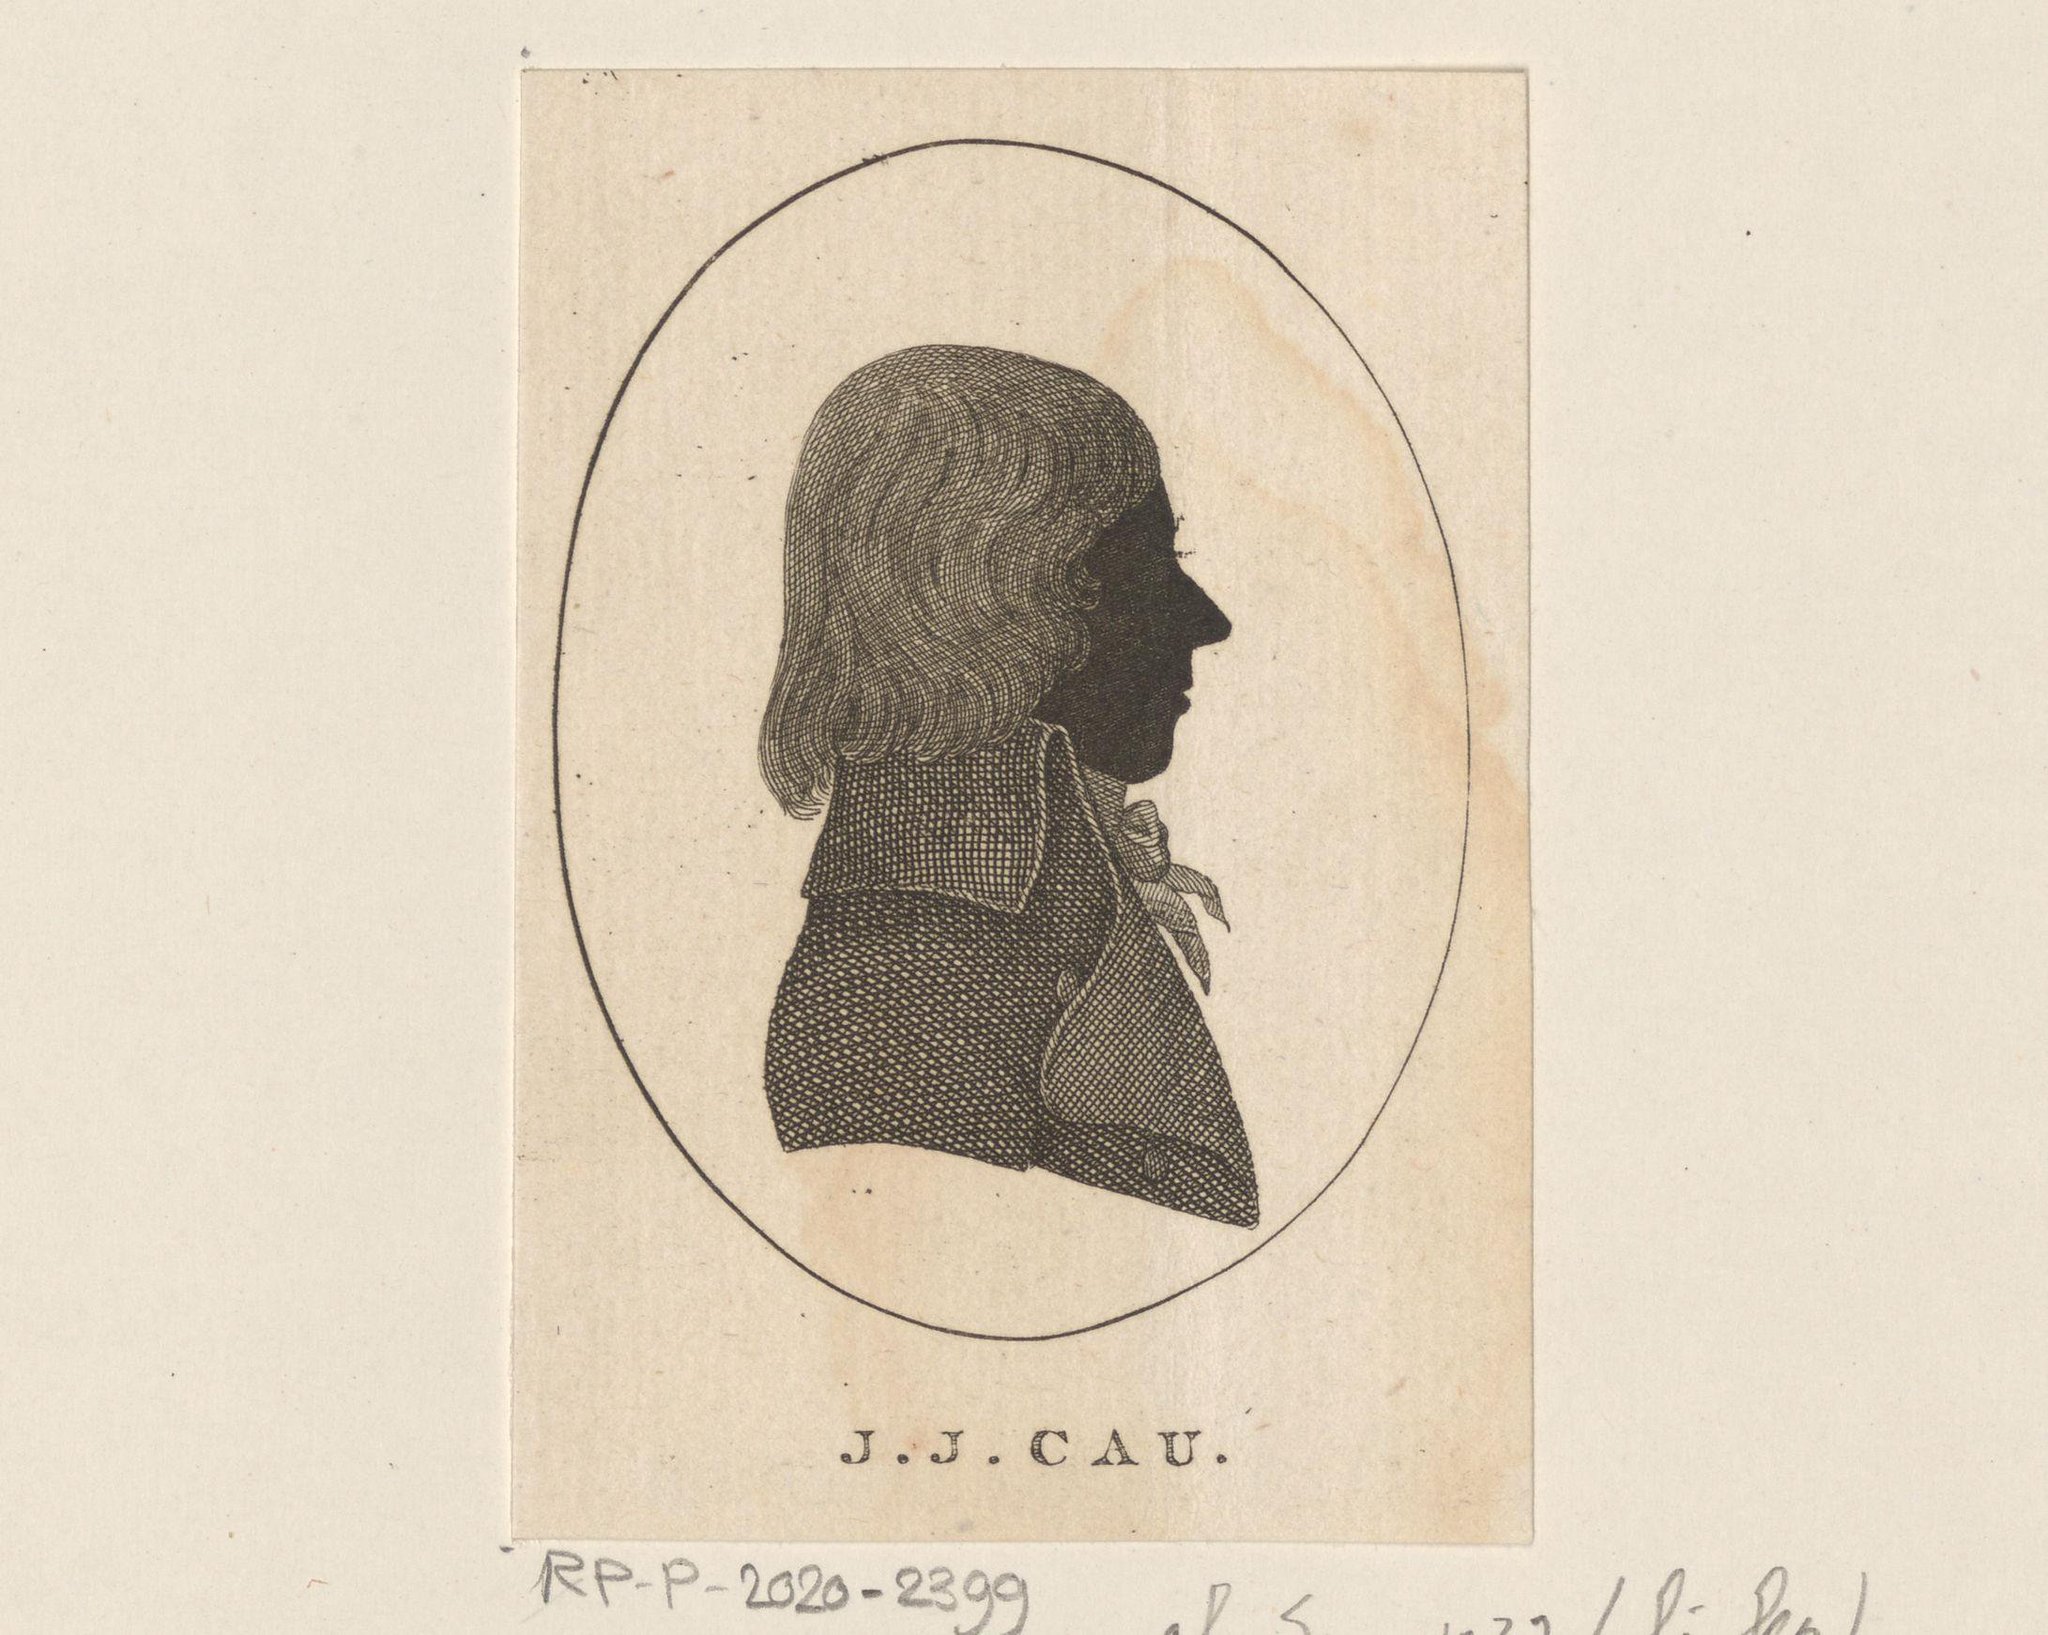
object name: print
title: Silhouetportret van Jan Jacob Cau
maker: Anonymous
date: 1799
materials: paper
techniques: etching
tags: historical persons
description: Prent waarschijnlijk uit: Rogge, Cornelis. Geschiedenis der staatsregeling voor het Bataafsche volk. Amsterdam: Johannes Allart, 1799.